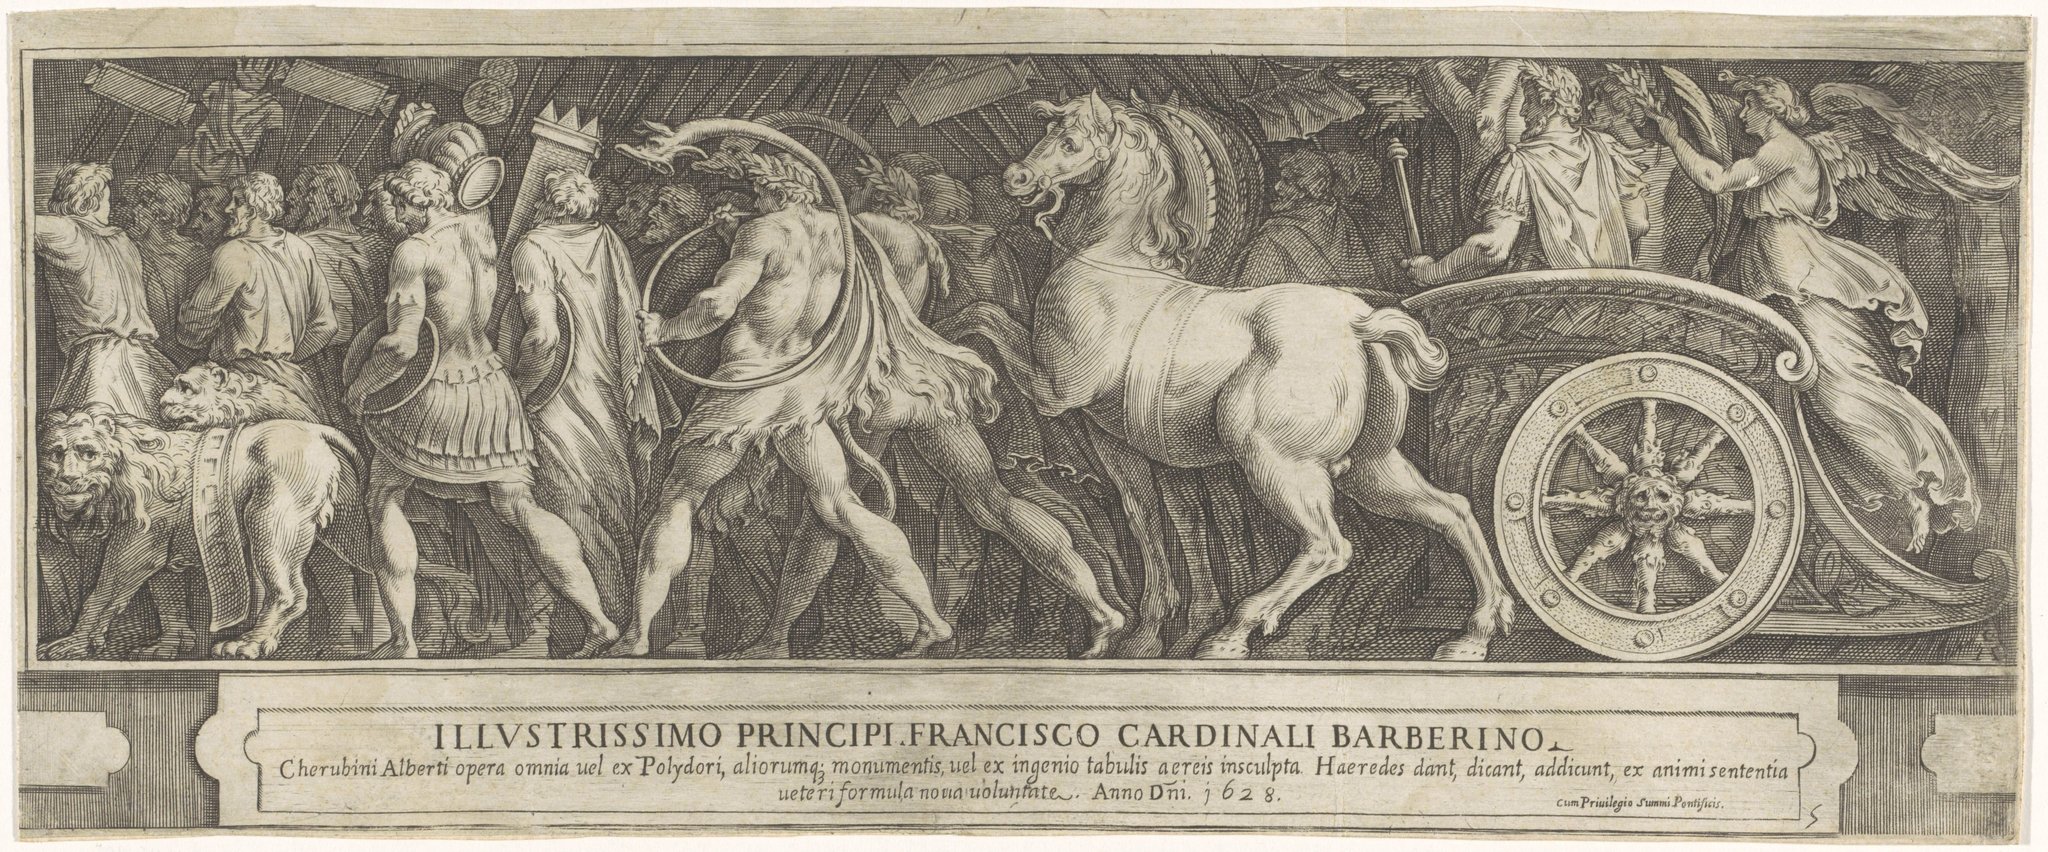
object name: print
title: Triomf van de twee Romeinse keizers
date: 1628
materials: paper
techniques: engraving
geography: italy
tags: conqueror triumphing, triumphal entry of victor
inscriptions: collector's mark: Lugt 11, collector's mark: ‘Hinloopen’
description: Een stoet van Romeinse soldaten, leeuwen en muzikanten voorafgaand aan een strijdwagen met twee Romeinse keizers en een gevleugelde figuur (Victoria). Op een plaquette onder de voorstelling tekst in het Latijn. Genummerd linksonder: 5.